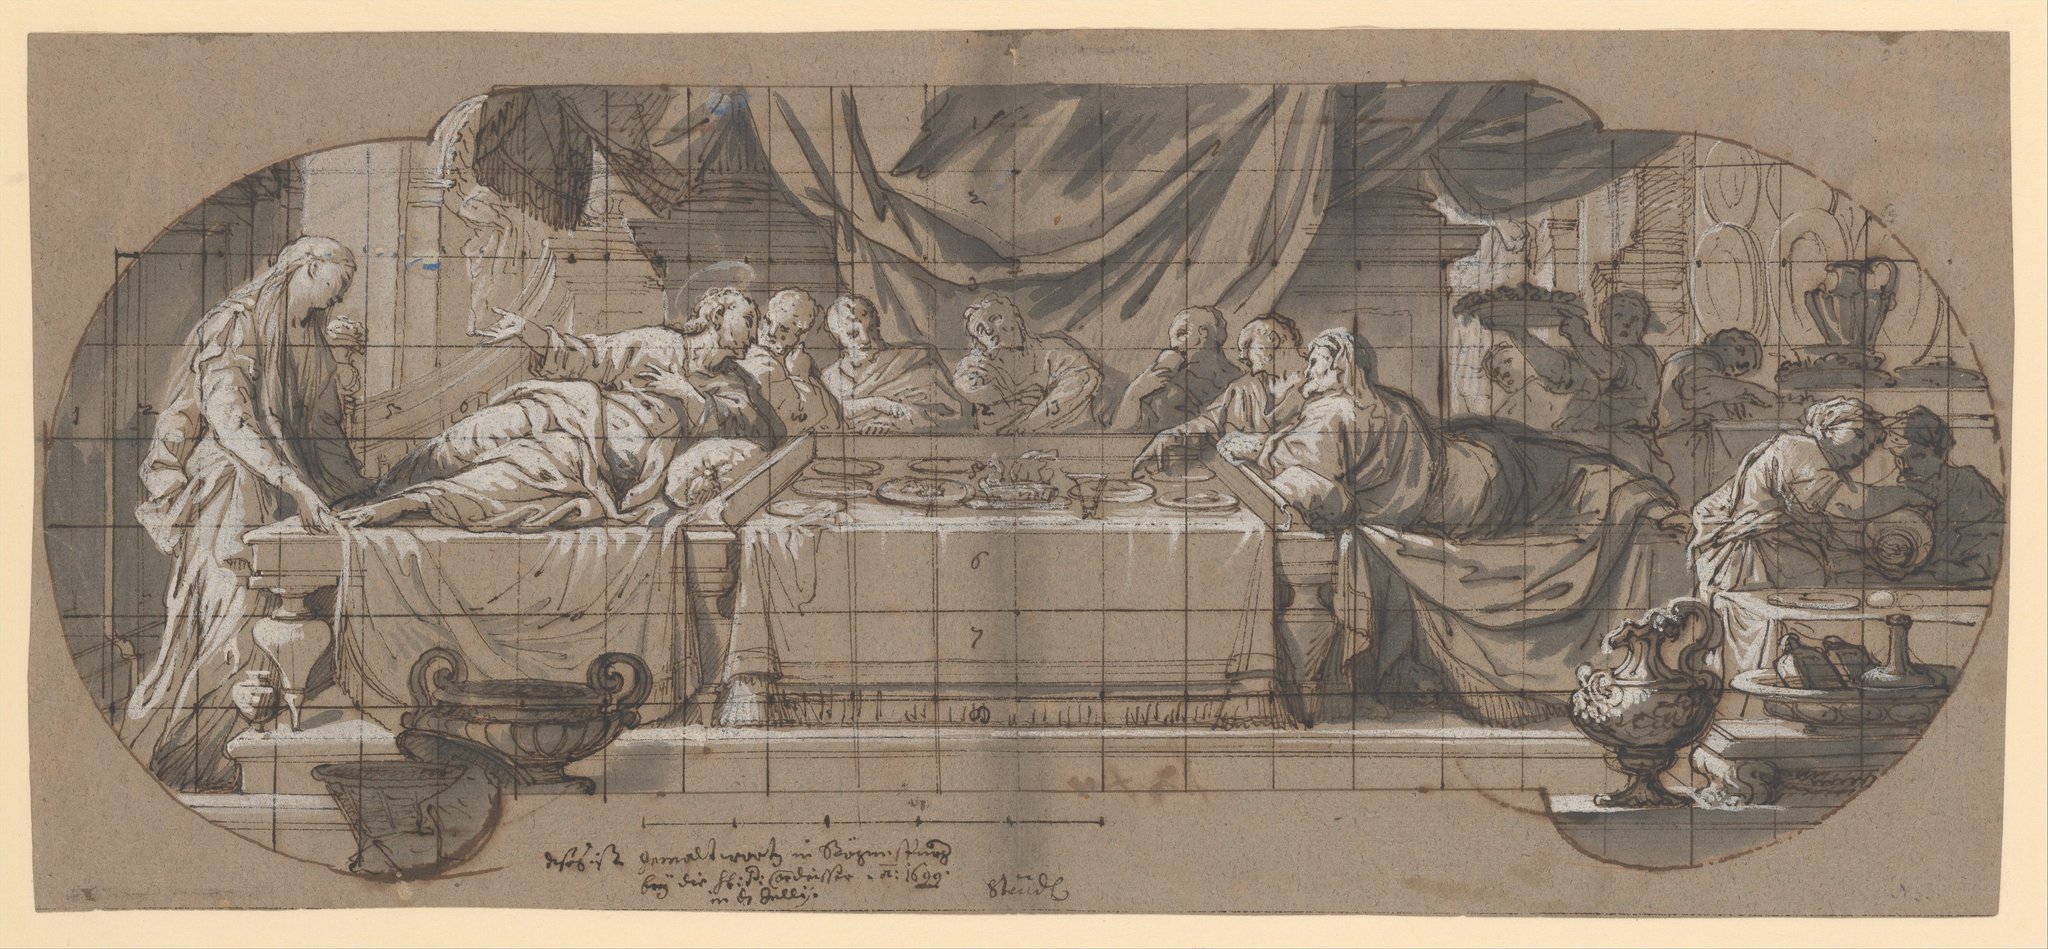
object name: drawing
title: Feast in the House of Simon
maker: melchior steidl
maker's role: artist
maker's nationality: austrian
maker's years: 1657-1727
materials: chalk, gouache, ink, paper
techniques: heightening, pen, drawing, wash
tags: men,women,dining